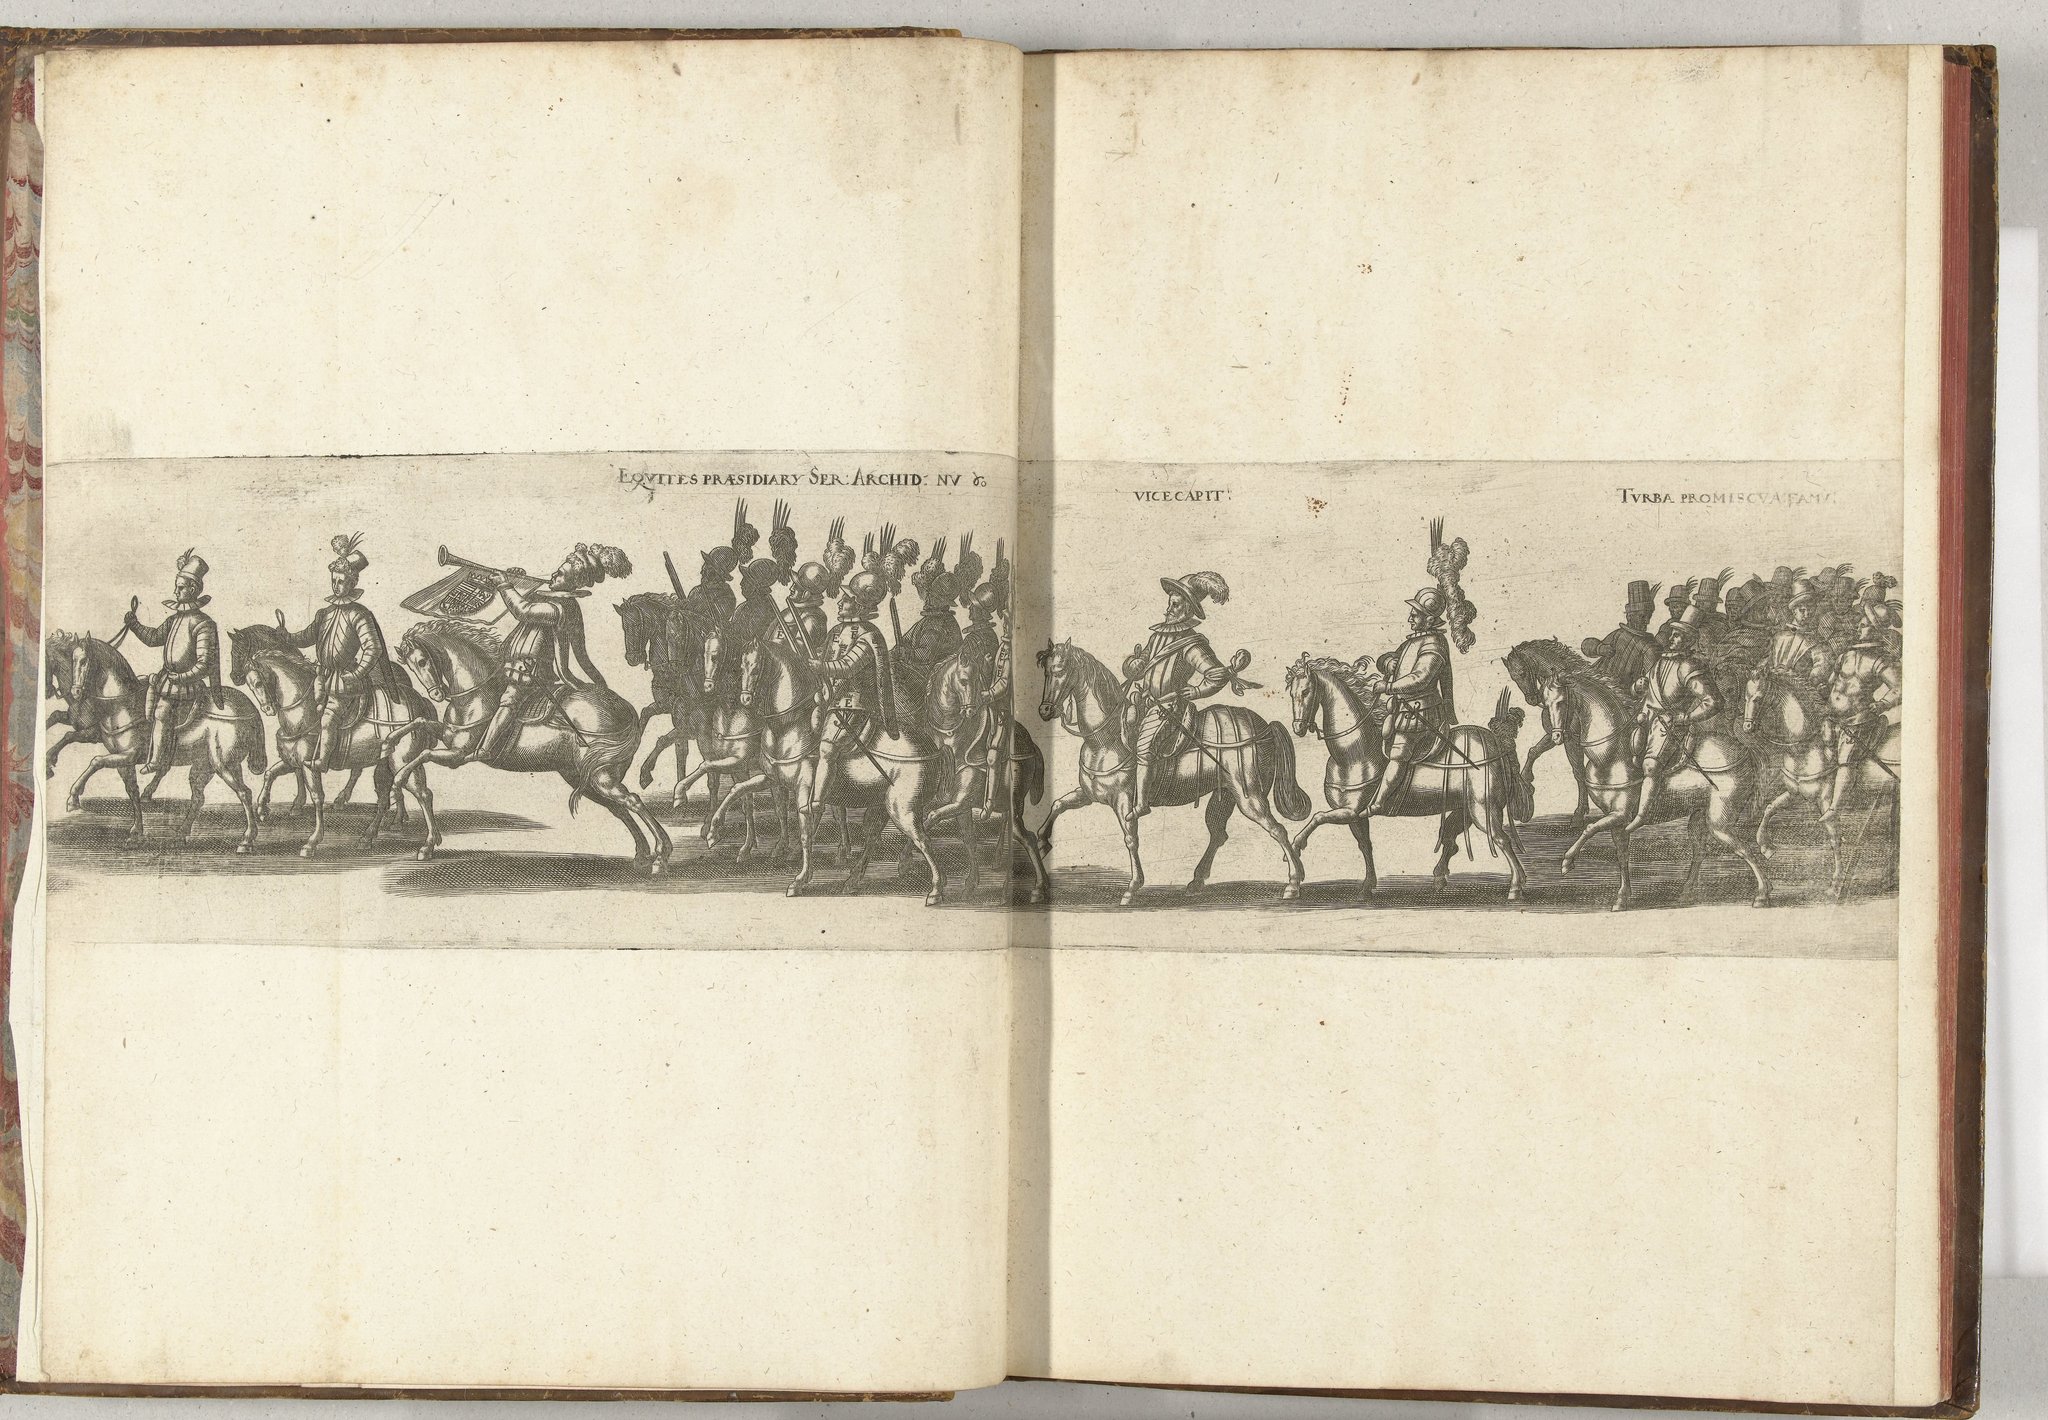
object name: print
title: De stoet met aartshertog Ernst bij de intocht te Brussel (deel 3), 1594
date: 1594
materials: paper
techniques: engraving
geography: brussels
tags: vienna, brussels, triumphal entry and public reception, pageant, 'entrée solennelle', 'joyeuse entrée'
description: De stoet met aartshertog Ernst bij de intocht te Brussel (deel 3), in het midden de erewacht van de aartshertog. Feestelijke intocht van aartshertog Ernst als gouverneur der Nederlanden gehouden te Brussel op 30 januari 1594. Onderdeel van de beschrijving van deze intocht Descriptio et explicatio pegmatum, arcuum spectaculorum quae Bruxellae Brabant. pridie Cal. Febr. Ao. 1594 exhibita fuere, sub ingressum ... Ernesti ... Archiducis Austriae ... pro Philippo II. Belgicae ditionis gubernatore, J. Mommaert, Brussel 1594.